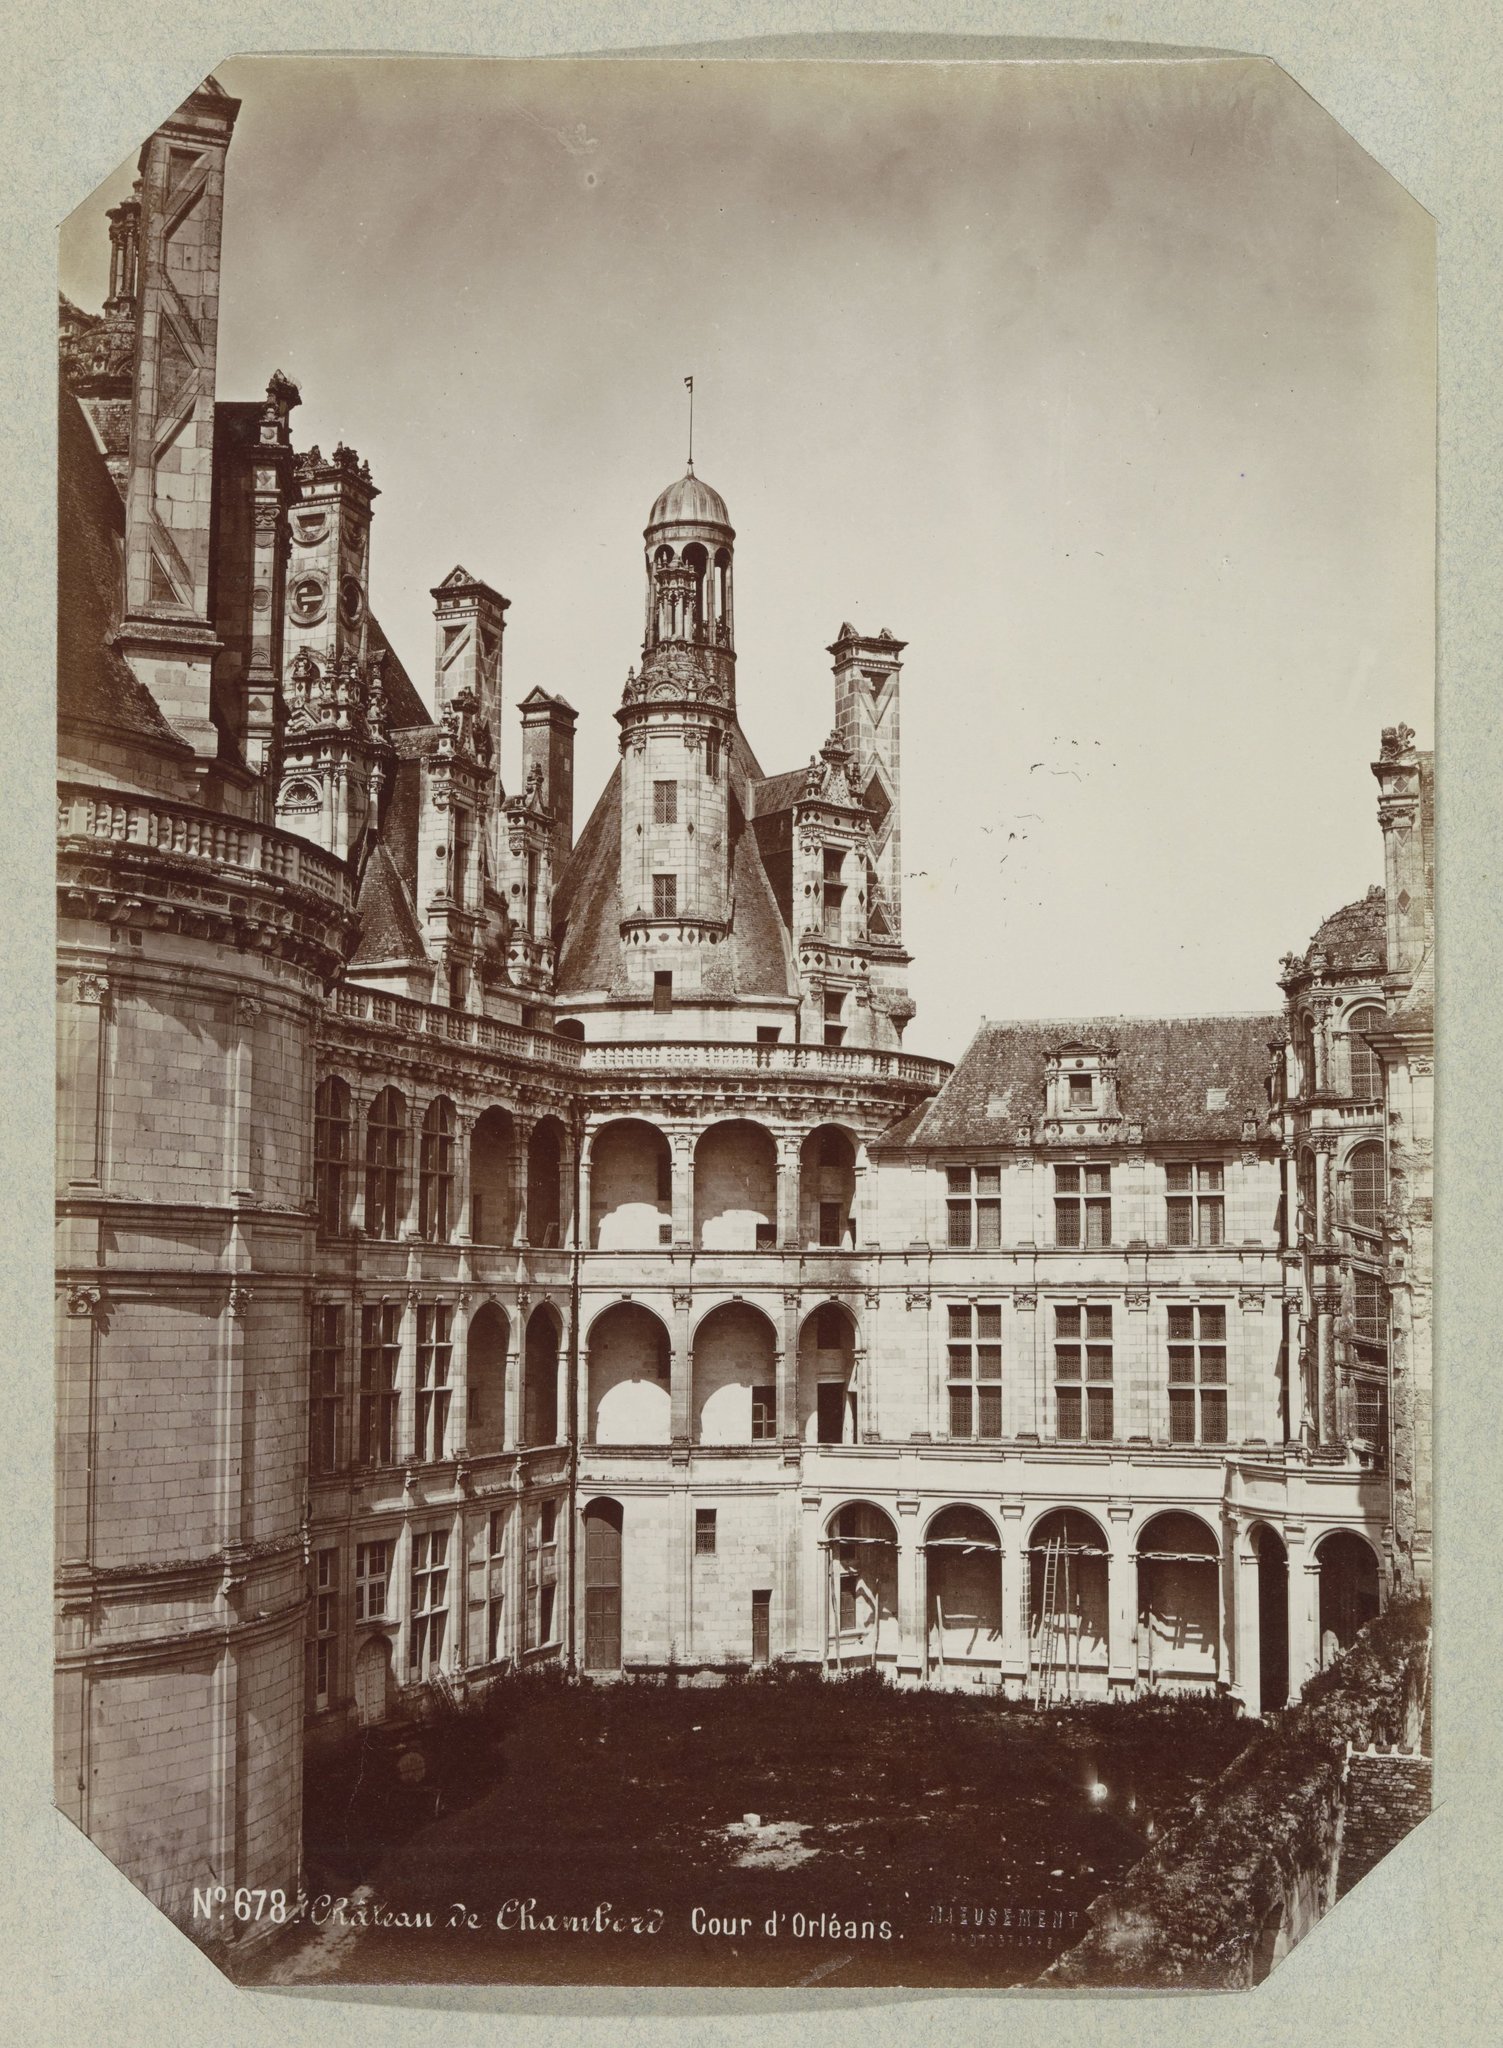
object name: photograph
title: Château de Chambord Cour d'Orléans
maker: séraphin-médéric mieusement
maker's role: fotograaf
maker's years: 1840-1905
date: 1880-1900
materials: photographic support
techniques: albumen print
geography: château de chambord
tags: tower, clock tower ~ monumental adornment, castle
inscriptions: inscription: ‘Monuments Historiques’, number: ‘678’, name: ‘Mieusement photographe’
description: Onderdeel van Fotoalbum met opnames van monumenten in Frankrijk.